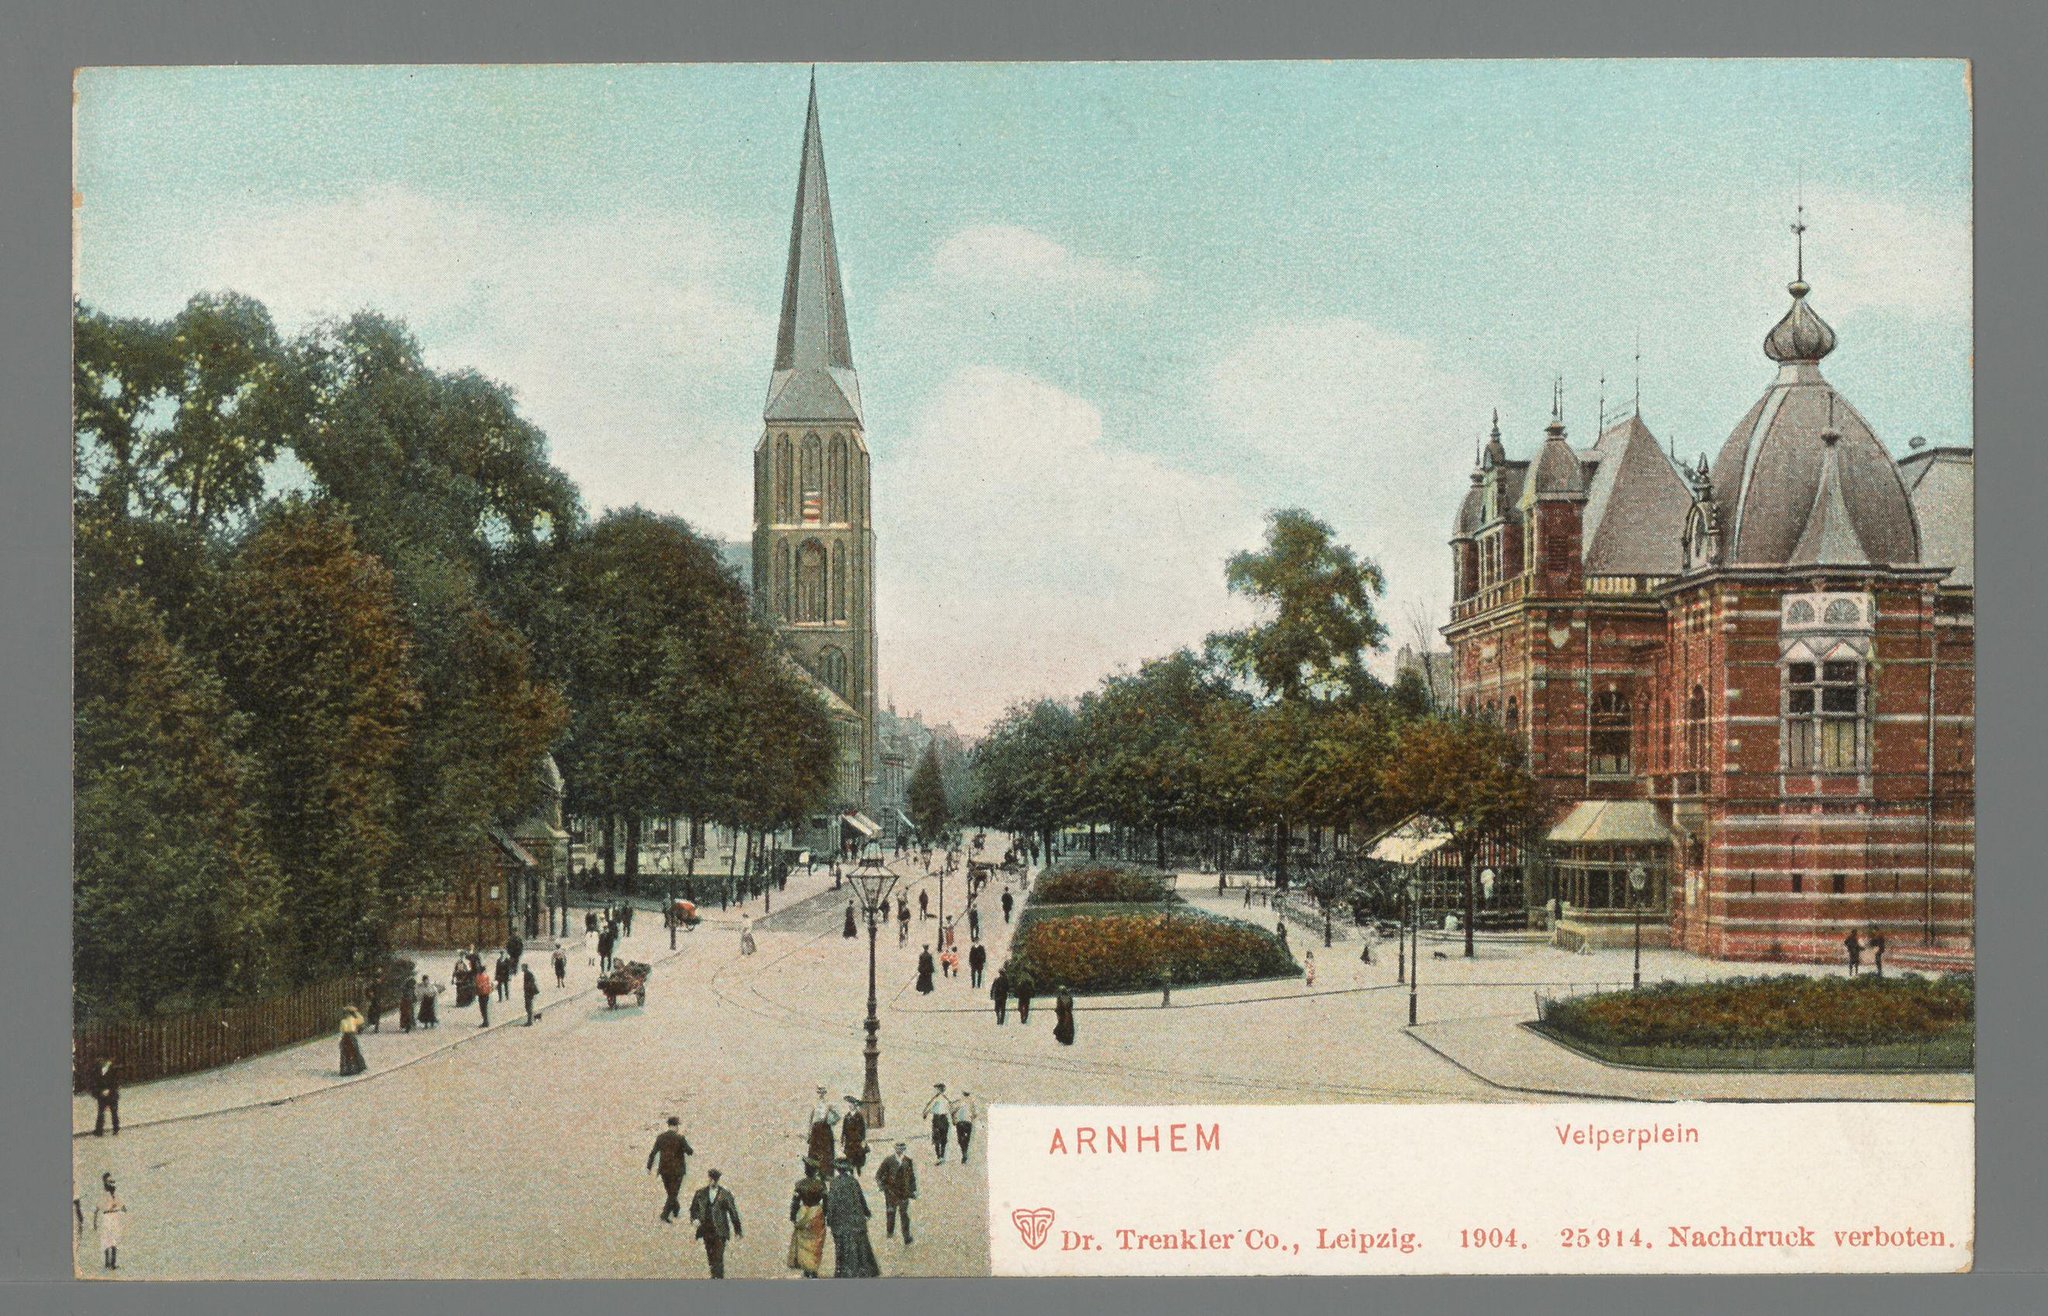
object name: photomechanical print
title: Arnhem. Velperplein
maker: Anonymous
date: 1904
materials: cardboard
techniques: lithograph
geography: leipzig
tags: square, place, circus, etc., church (exterior), street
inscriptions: date